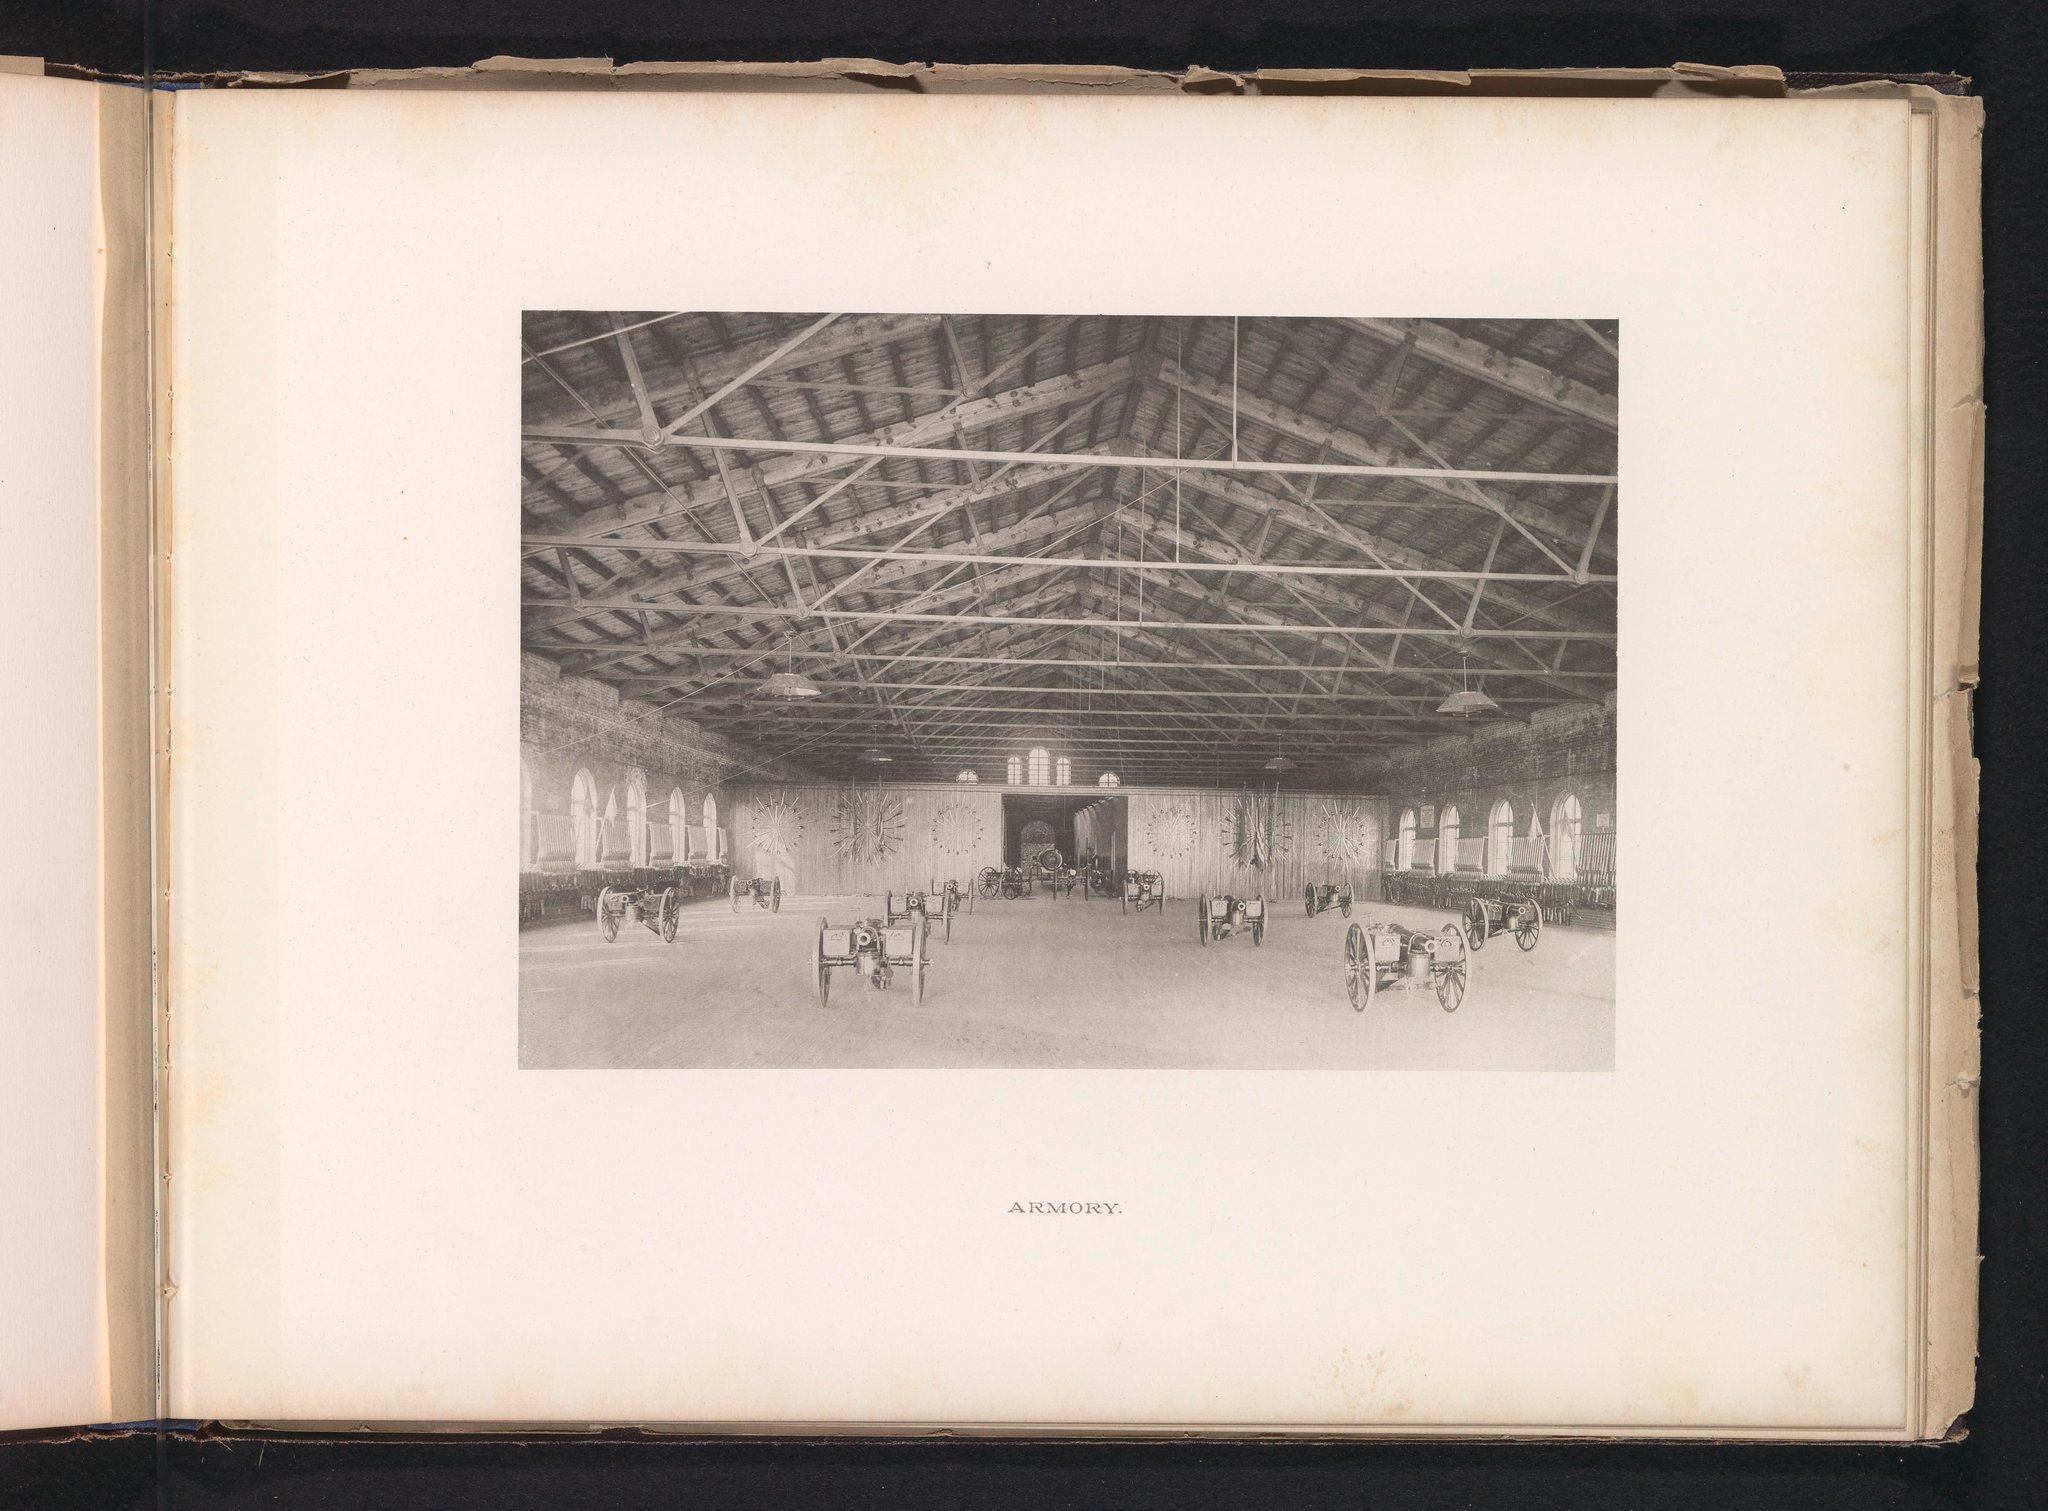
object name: page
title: Armory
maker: edward h. hart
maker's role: publisher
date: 1885-1890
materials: paper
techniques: photograph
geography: new york city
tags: firearms: cannon, ammunition store, arsenal